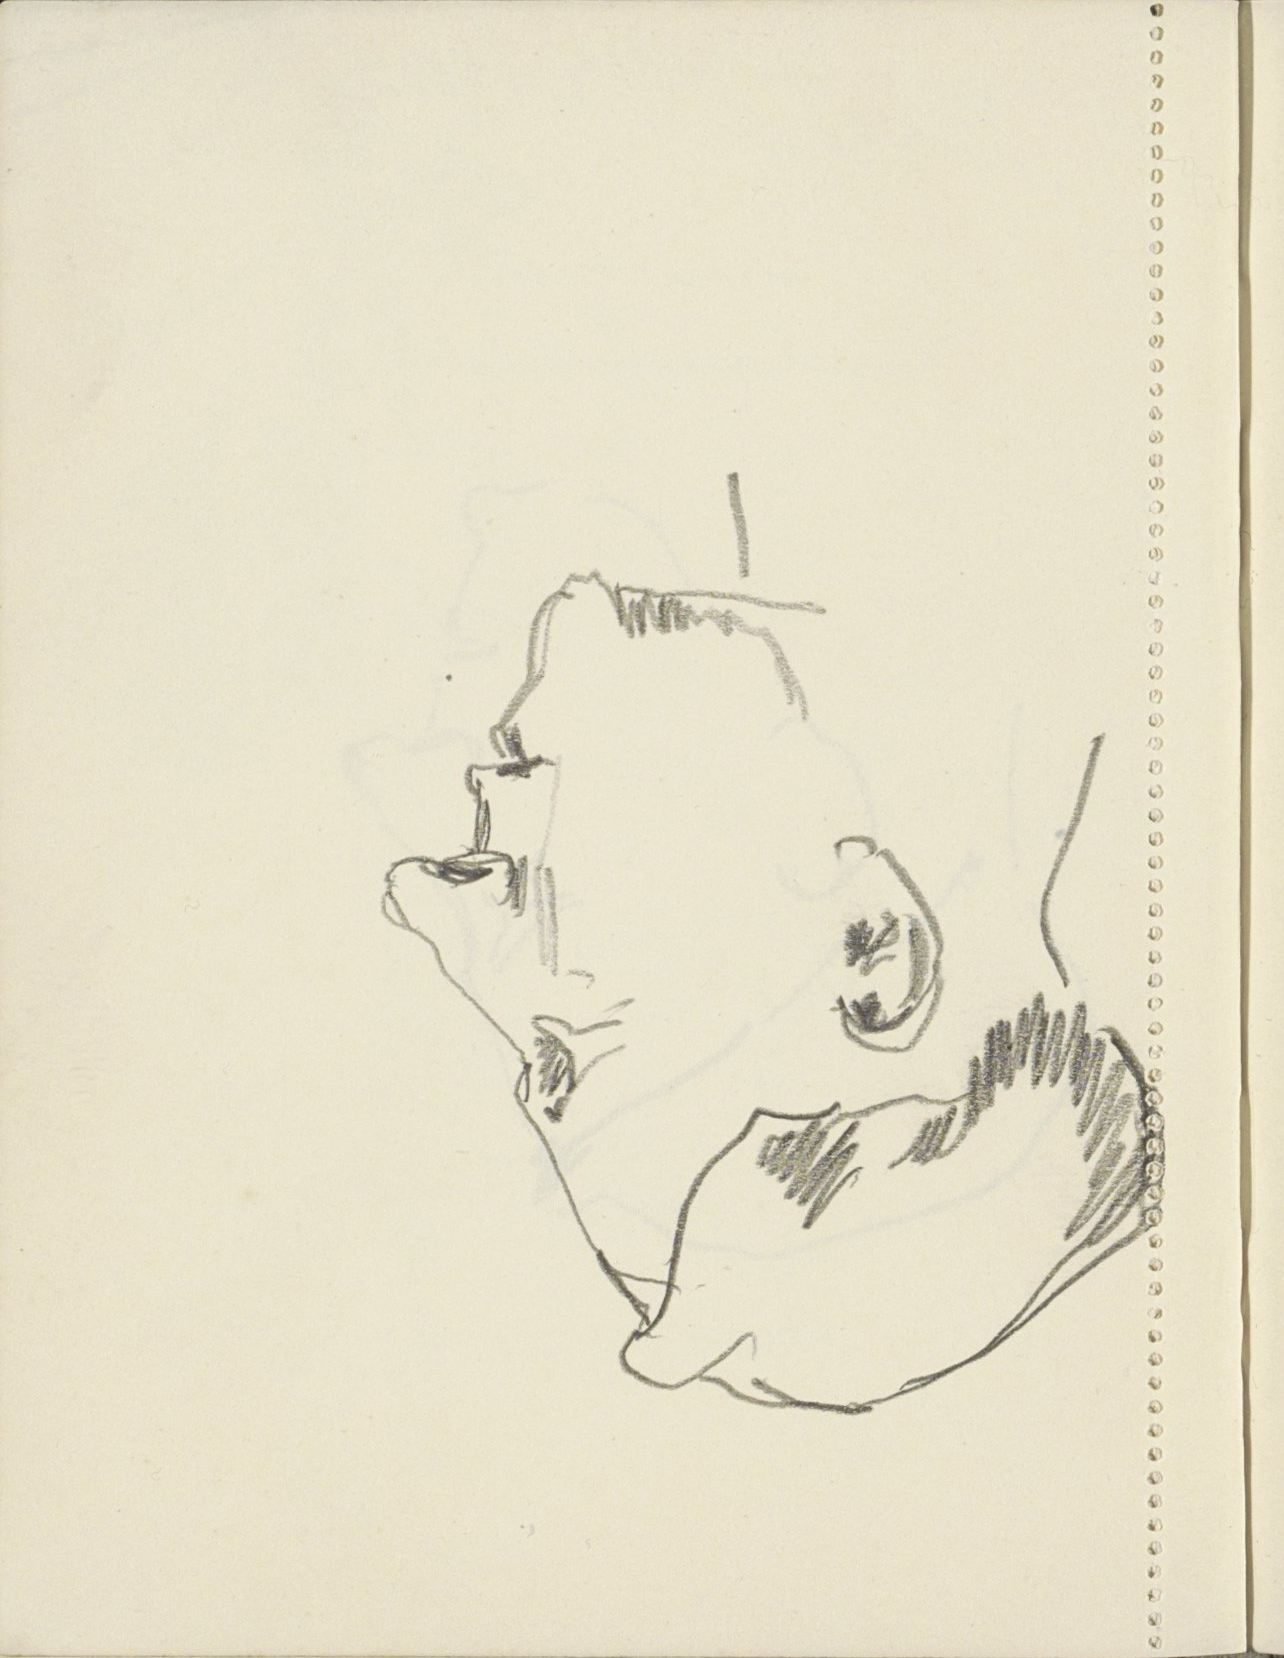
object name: sketchbook leaf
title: Kop van een man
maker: cornelis vreedenburgh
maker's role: draughtsman, print maker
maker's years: 1880-1946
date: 1890-1946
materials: paper, pencil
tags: head (human)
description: Blad 63 verso uit een schetsboek met 71 bladen.